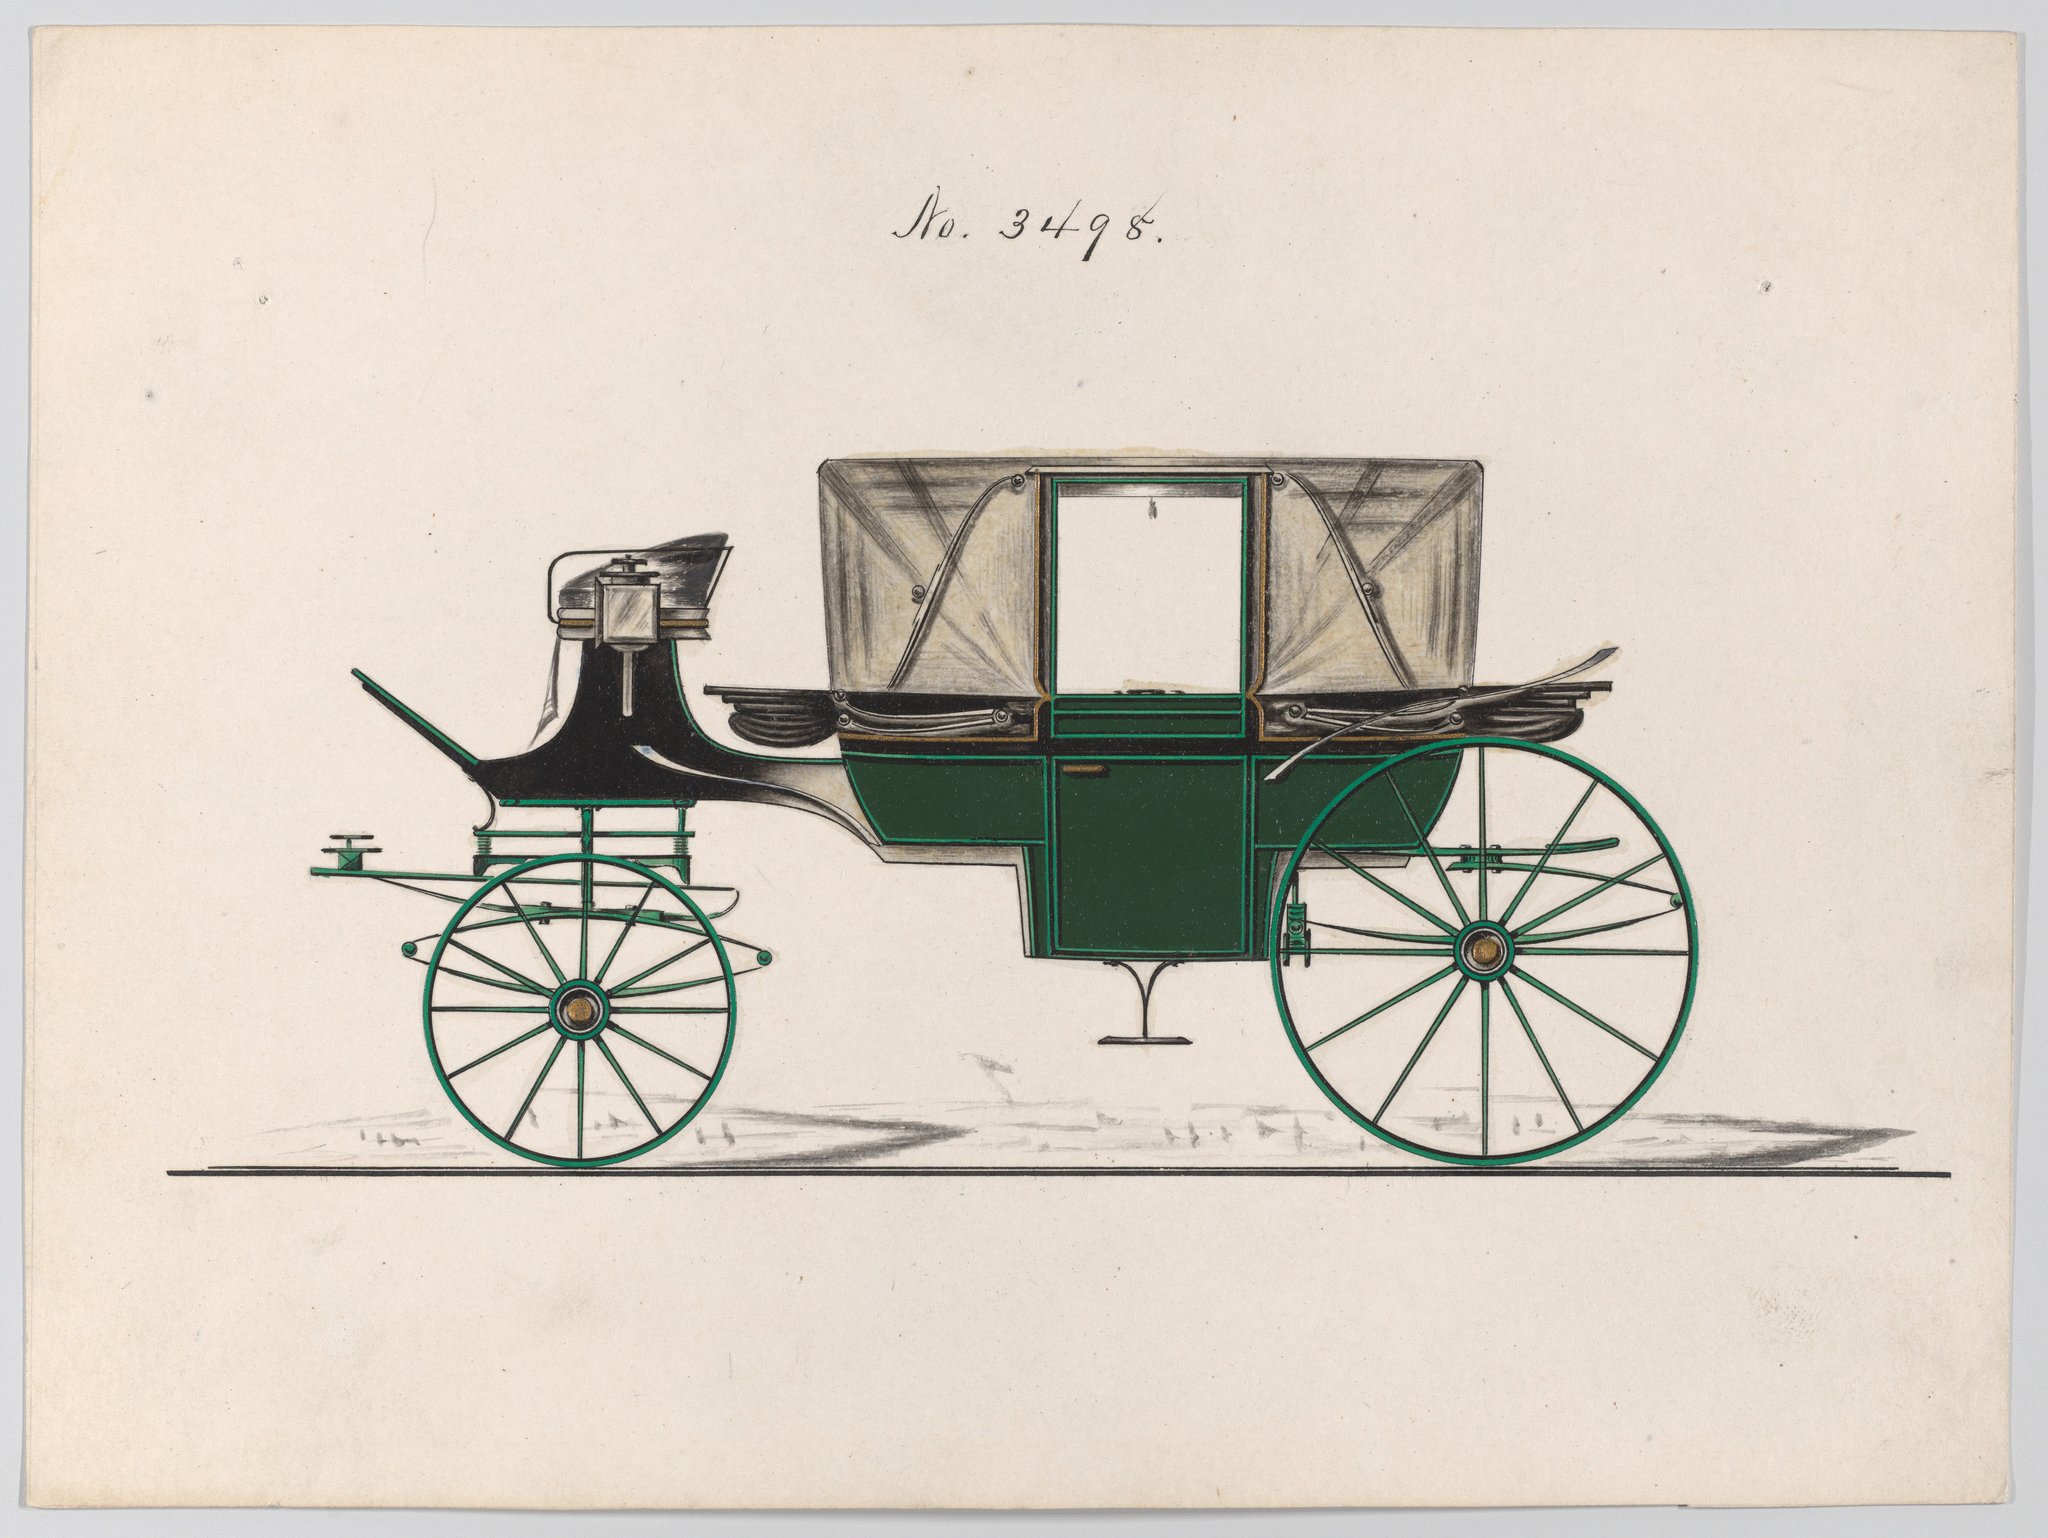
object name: drawing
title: Design for Landau, No. 3498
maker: brewster & co.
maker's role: manufacturer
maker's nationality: american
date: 1879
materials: gouache, gum arabic, ink, watercolor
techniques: pen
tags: carriages